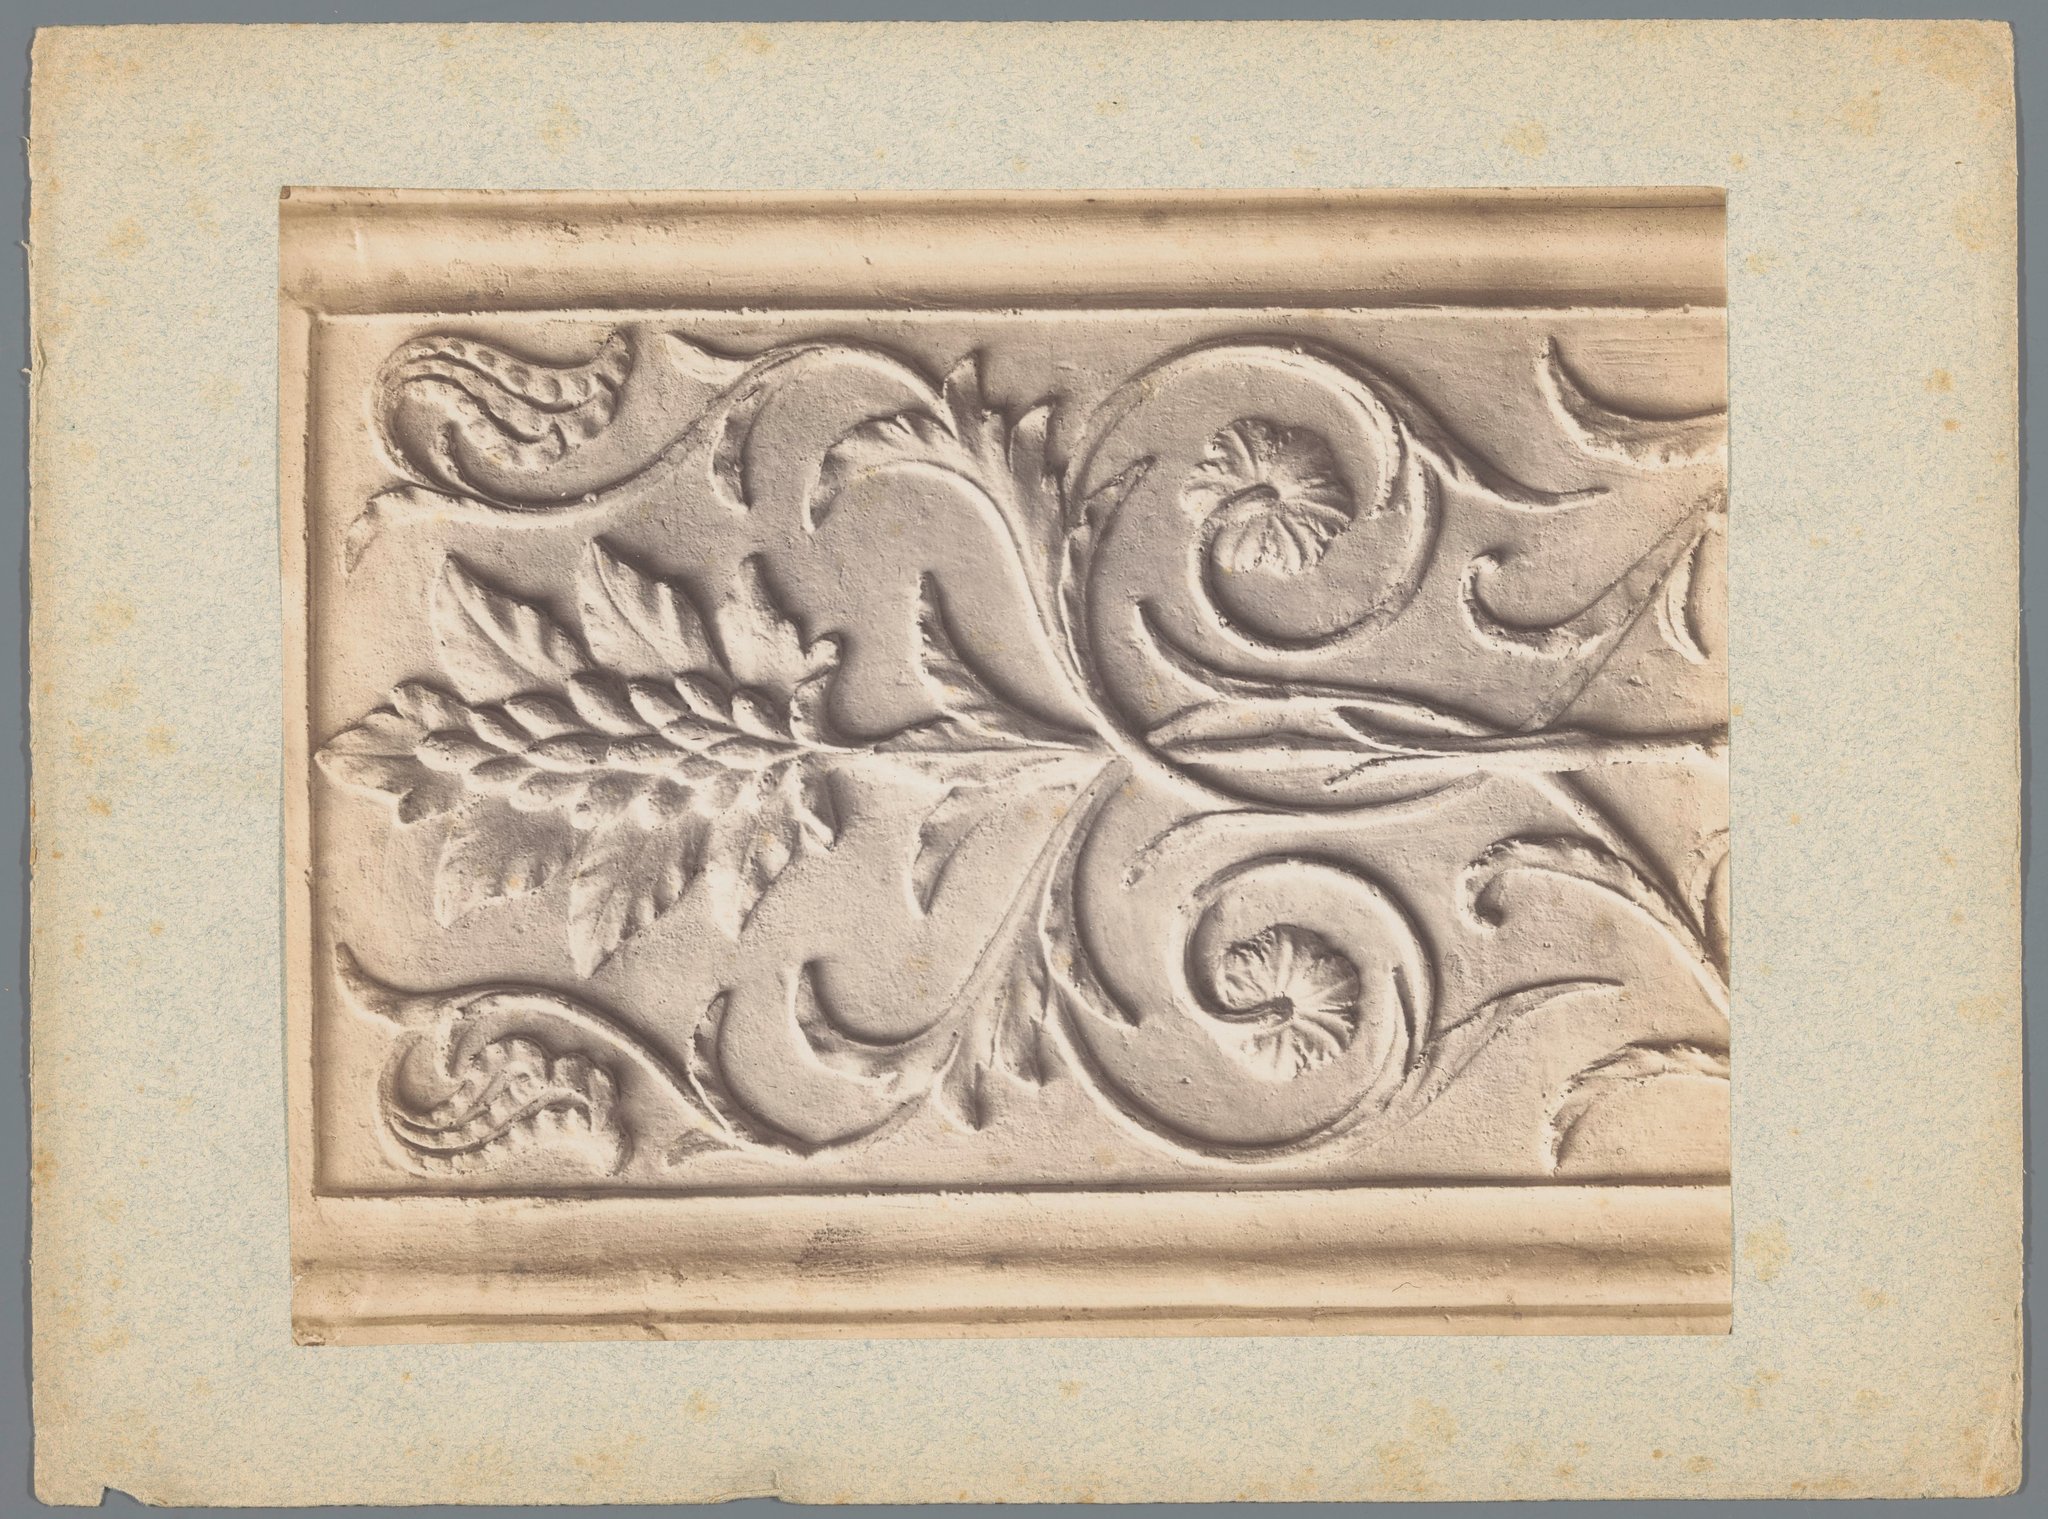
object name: photograph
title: Reliëf met een plantmotief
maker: Anonymous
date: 1875-1900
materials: cardboard, photographic support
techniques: albumen print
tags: ornament derived from plant forms, sculpture (+ relief ~ sculpture)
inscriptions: inscription: ‘XII k 3 pl 7’, collector's mark: Lugt 3937